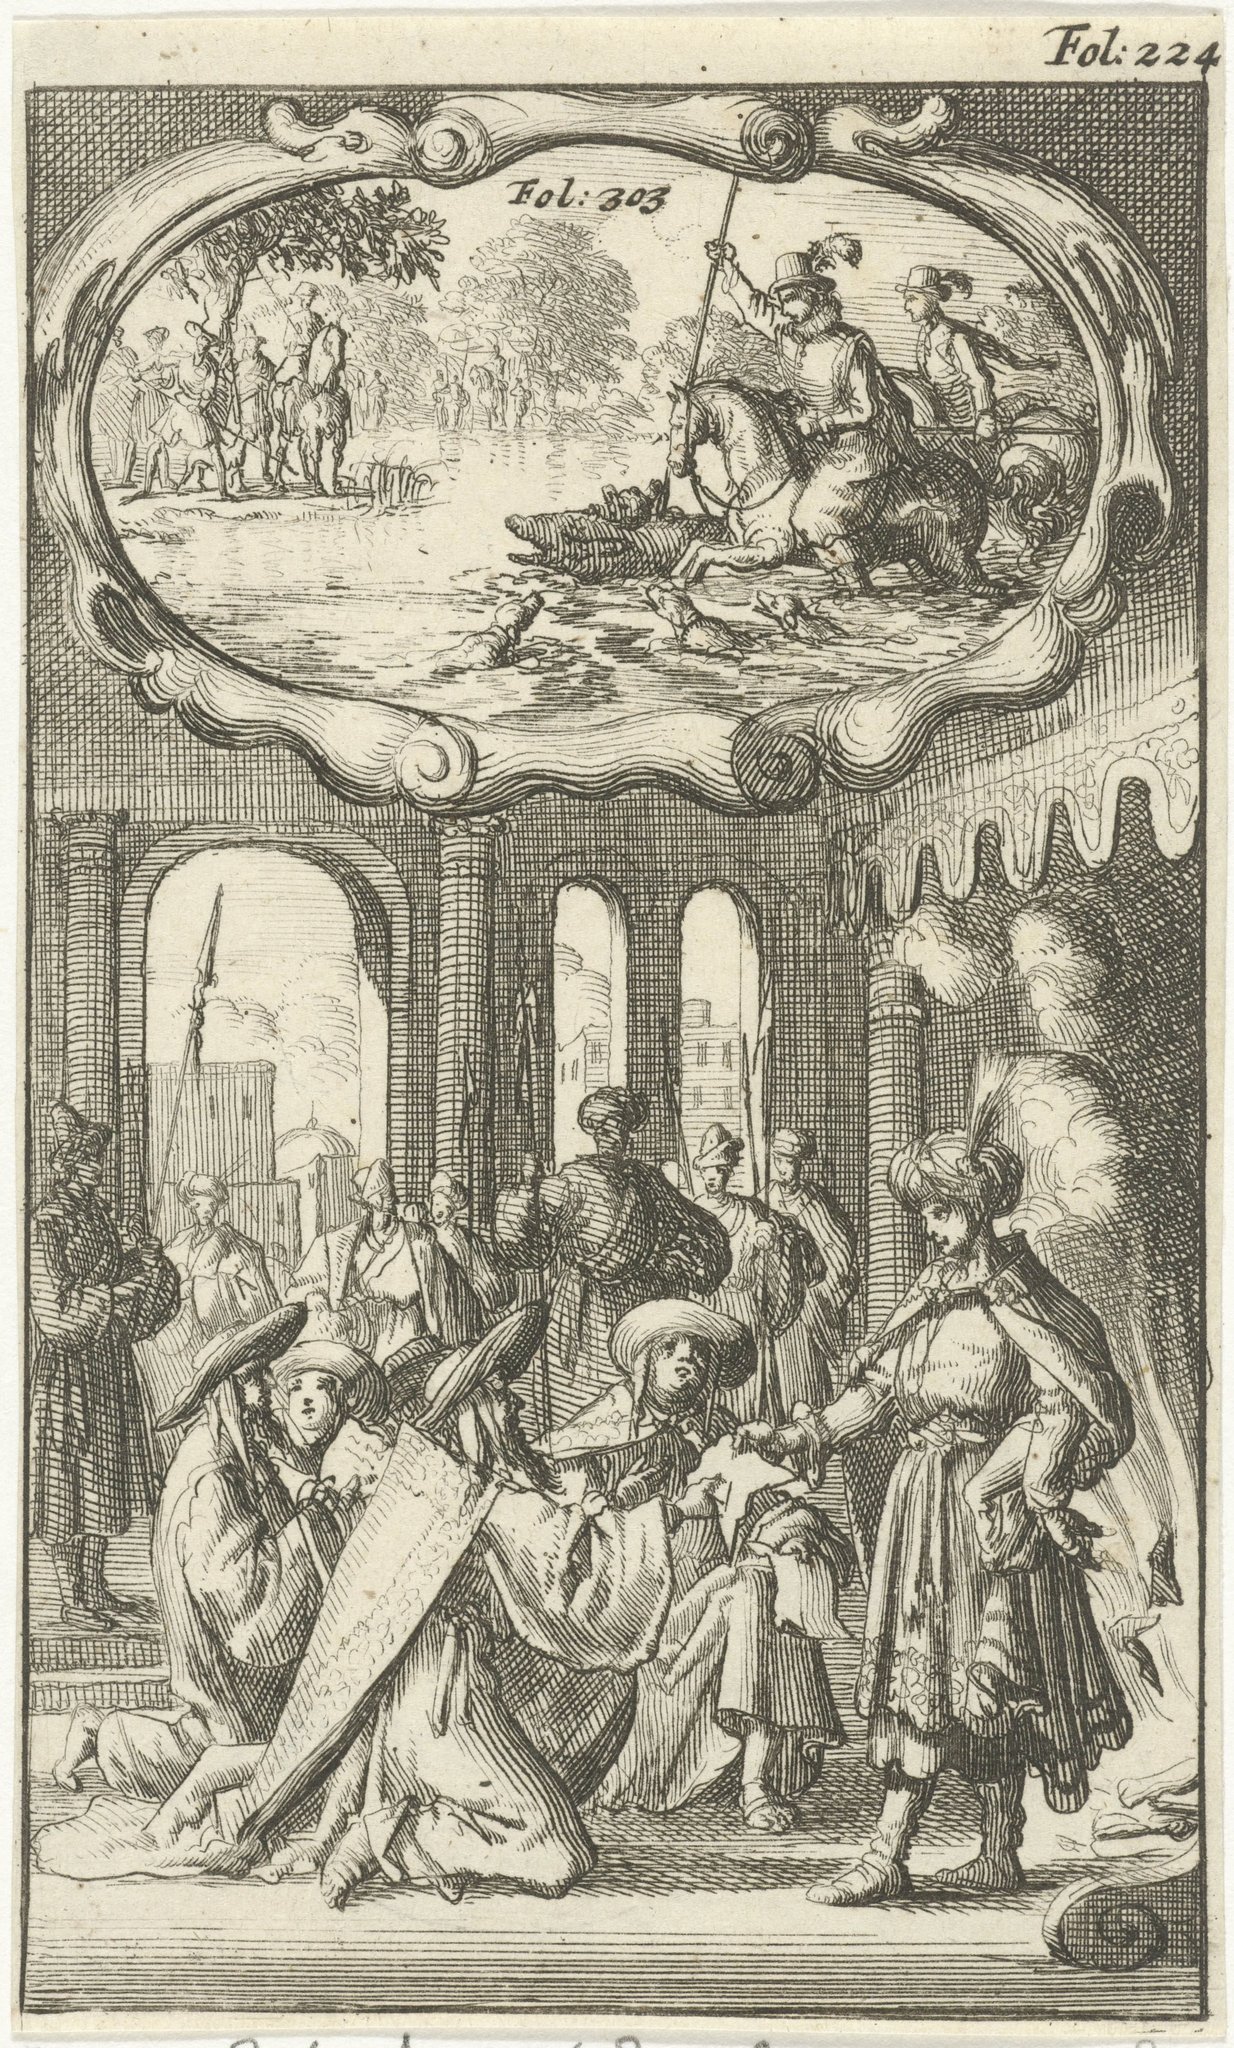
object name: print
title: Constantijn de Grote met bisschoppen te Nicene / Prins van Aragon, zoon van koning Alfons Ferdinand, op berenjacht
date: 1687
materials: paper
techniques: etching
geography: amsterdam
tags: archbishop, bishop, etc. (roman catholic), beasts of prey, predatory animals: bear, hunt ~ mammals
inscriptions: collector's mark: Lugt 2228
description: Illustratie uit: Ziegler, Georg. Konst-spiegel der weereltlikke vermaken. Amsterdam: Johannes Boekholt, 1687.